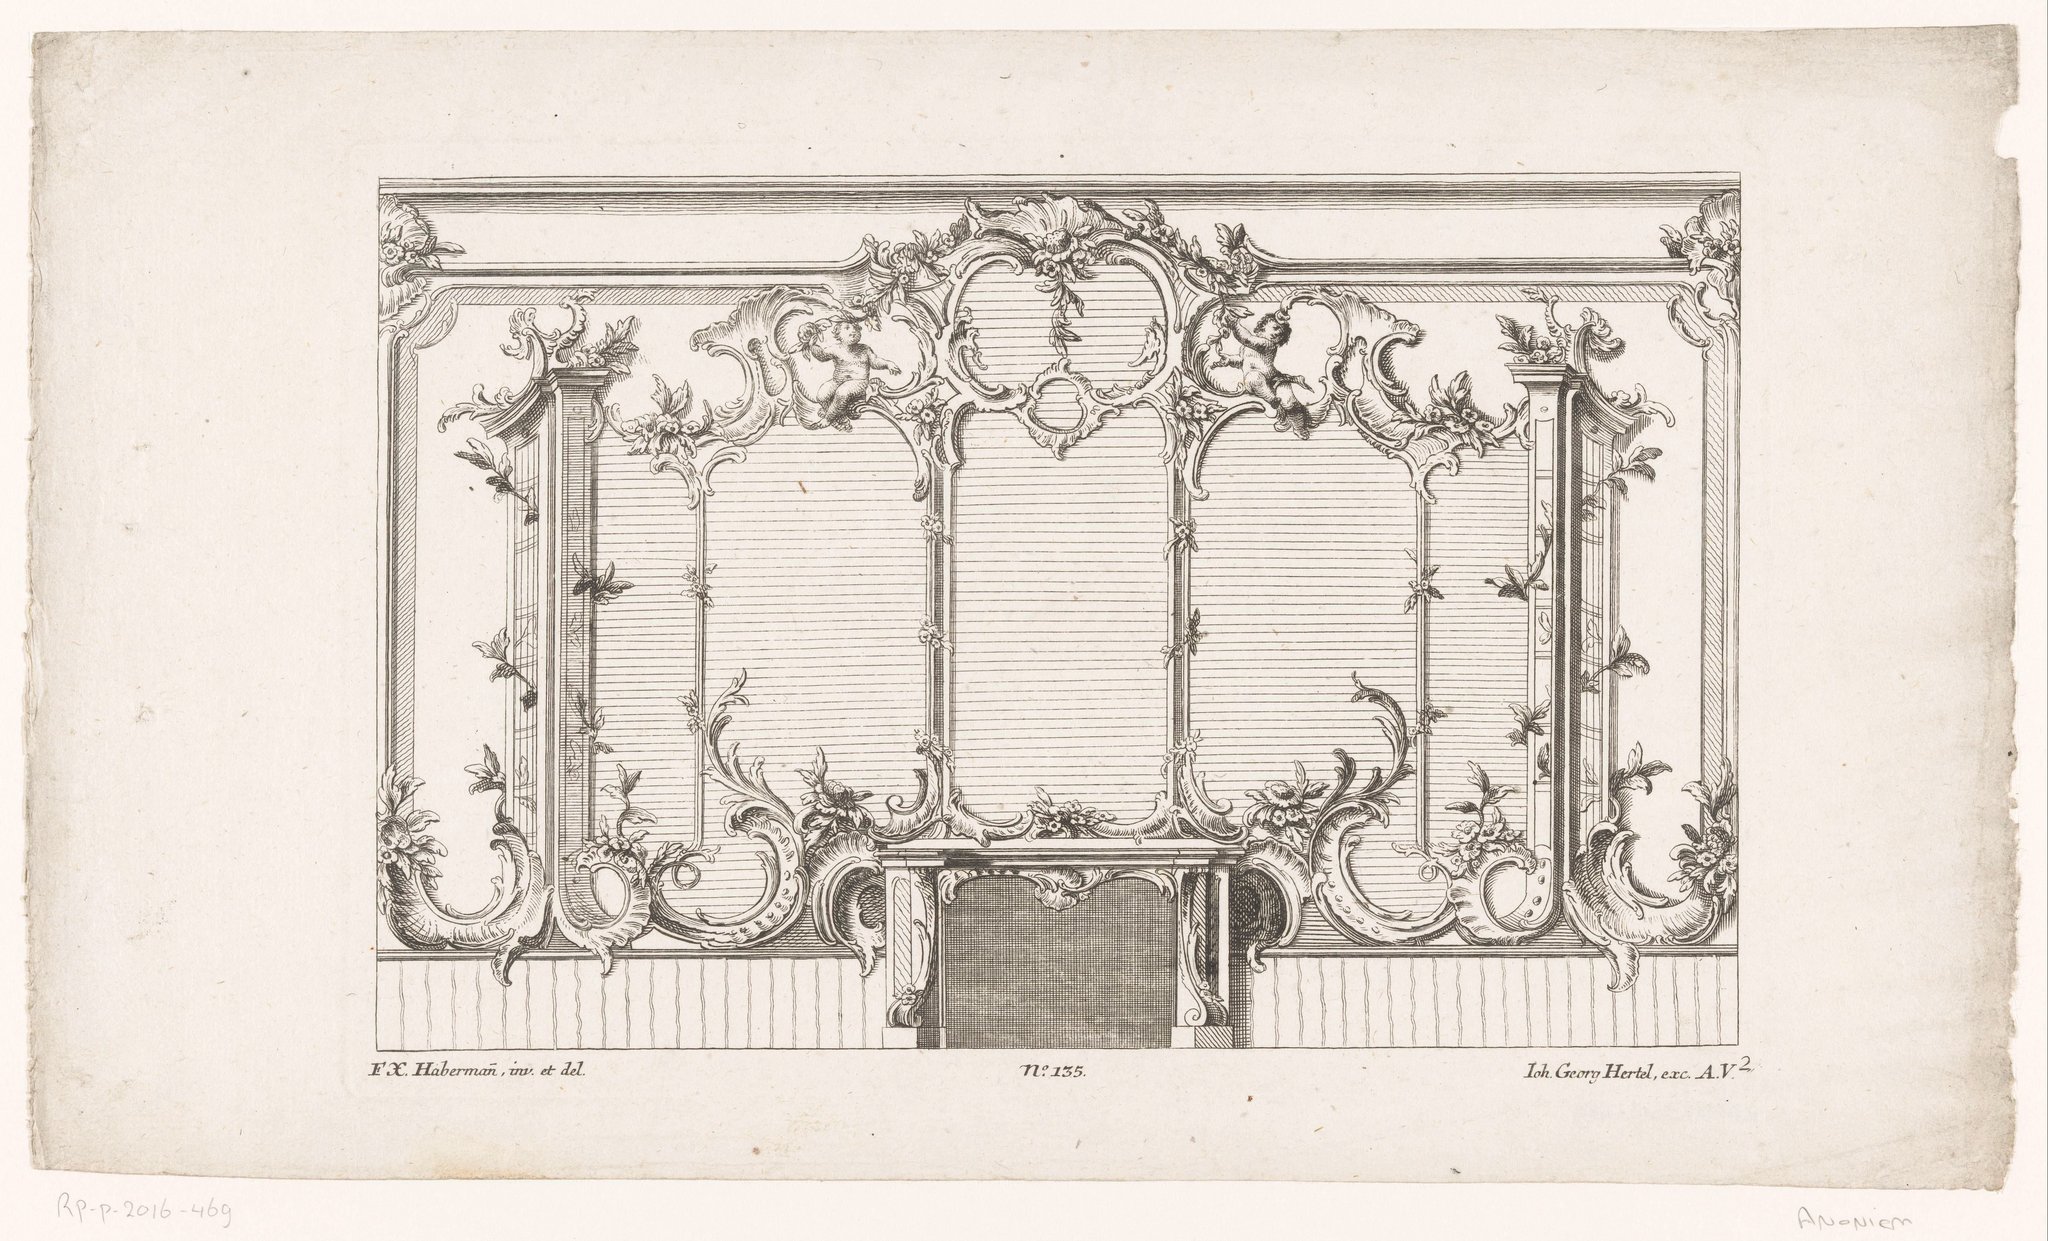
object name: ornament print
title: Wandindelingen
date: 1748-1753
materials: paper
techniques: engraving, etching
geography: augsburg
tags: rocaille ornament, panelling, open hearth, fire-place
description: Wandindeling met schouw en panelen met rocaille omlijsting met putti. Uitgeversnummer 135.